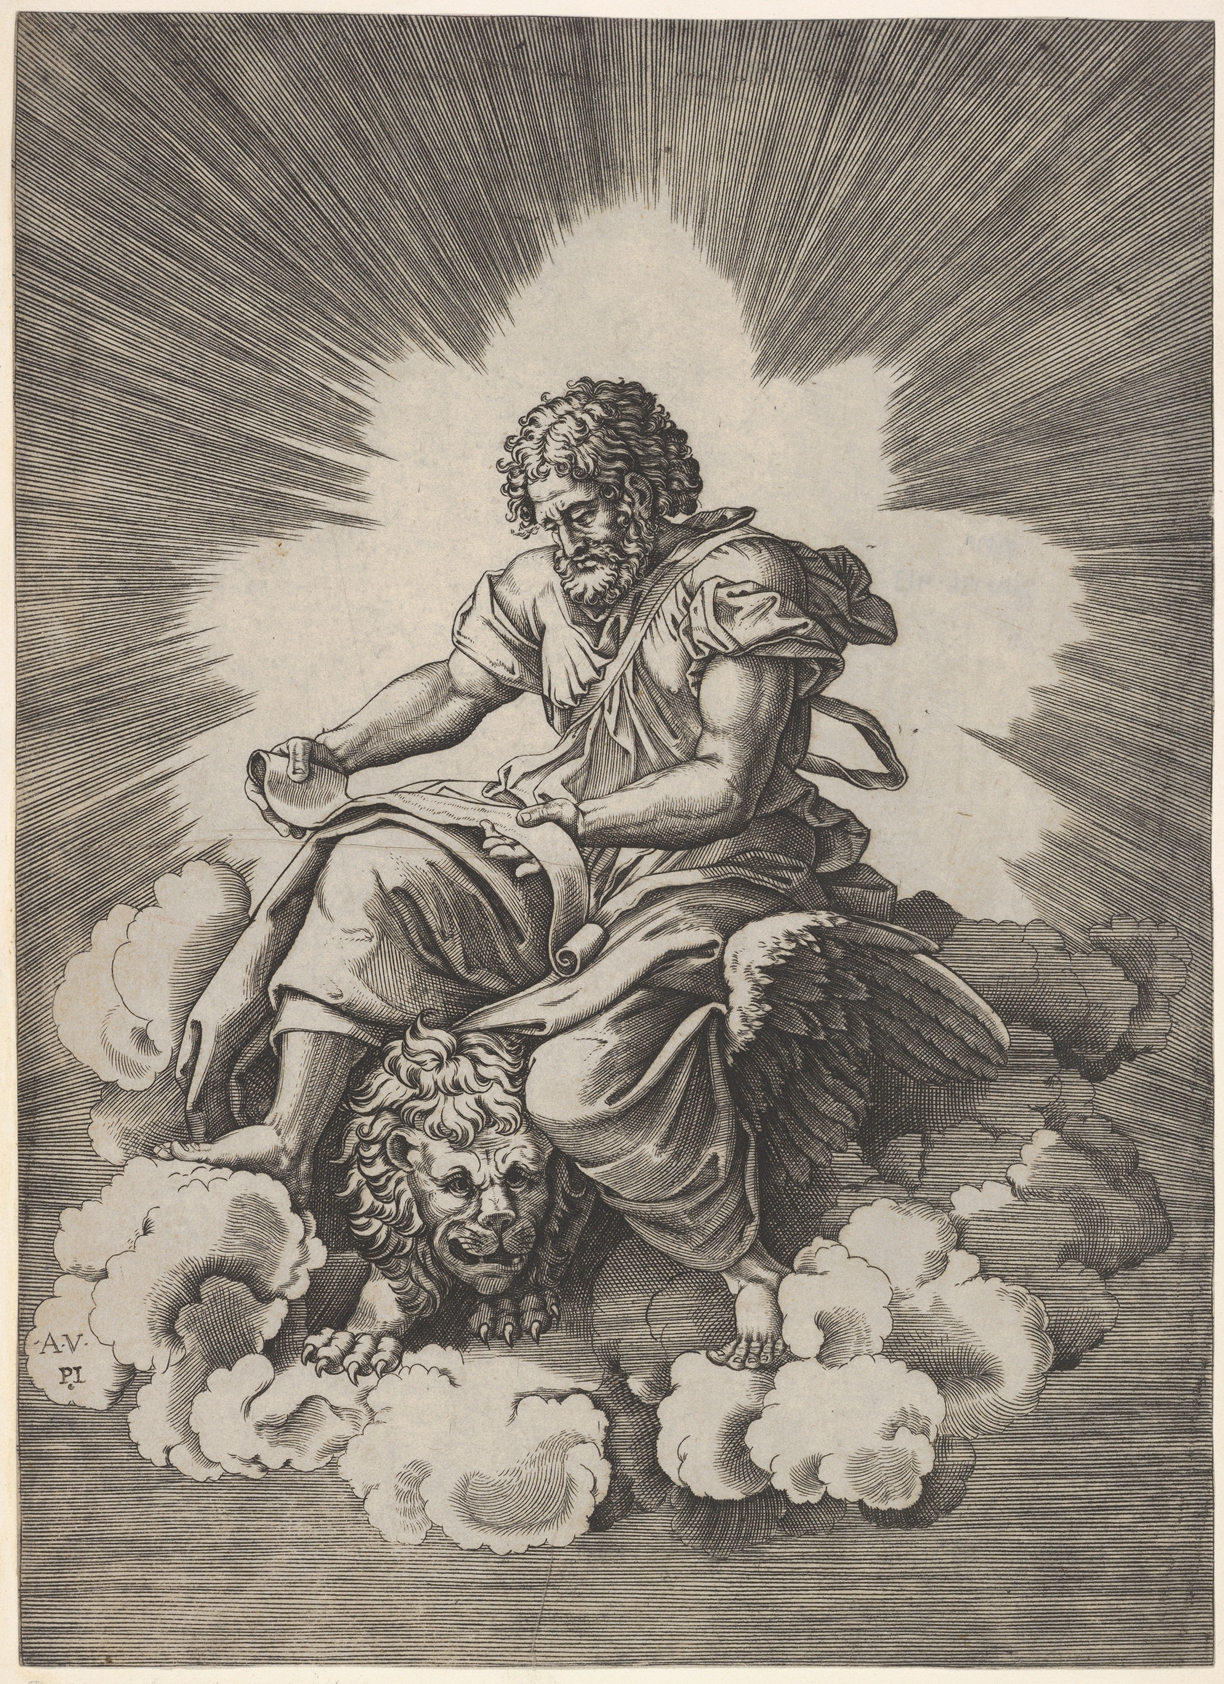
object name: print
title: St. Mark, seated with an unfurled scroll in his hands, a winged lion's head and forefeet emerge beneath his robes, from a series of the four evangelists after Agostino Veneziano, which are in turn after Giulio Romano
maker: anonymous, italian, 16th century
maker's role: artist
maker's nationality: italian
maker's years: 1500-1600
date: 1518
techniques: engraving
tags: scrolls,saint mark